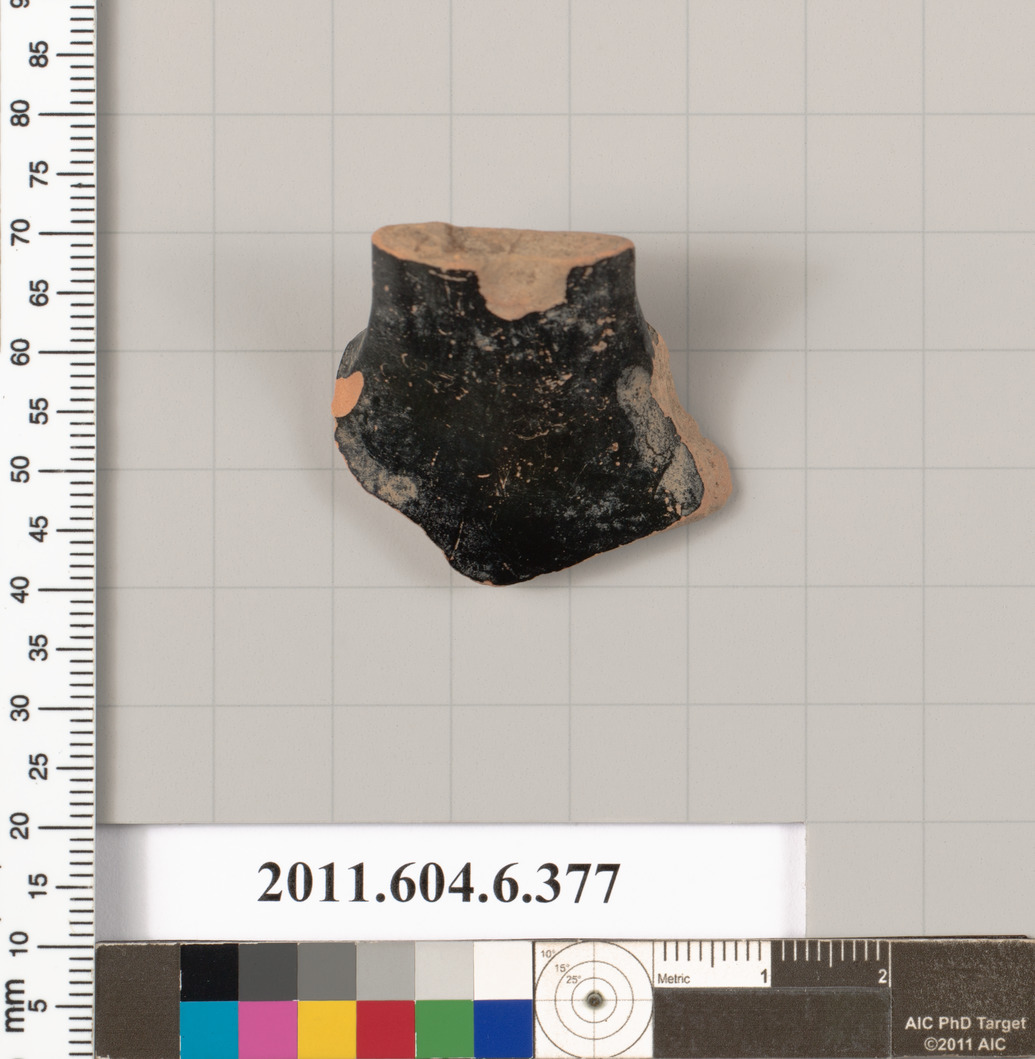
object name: undetermined shape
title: Terracotta fragment of an undetermined shape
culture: greek, attic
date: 600-401 BCE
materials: terracotta